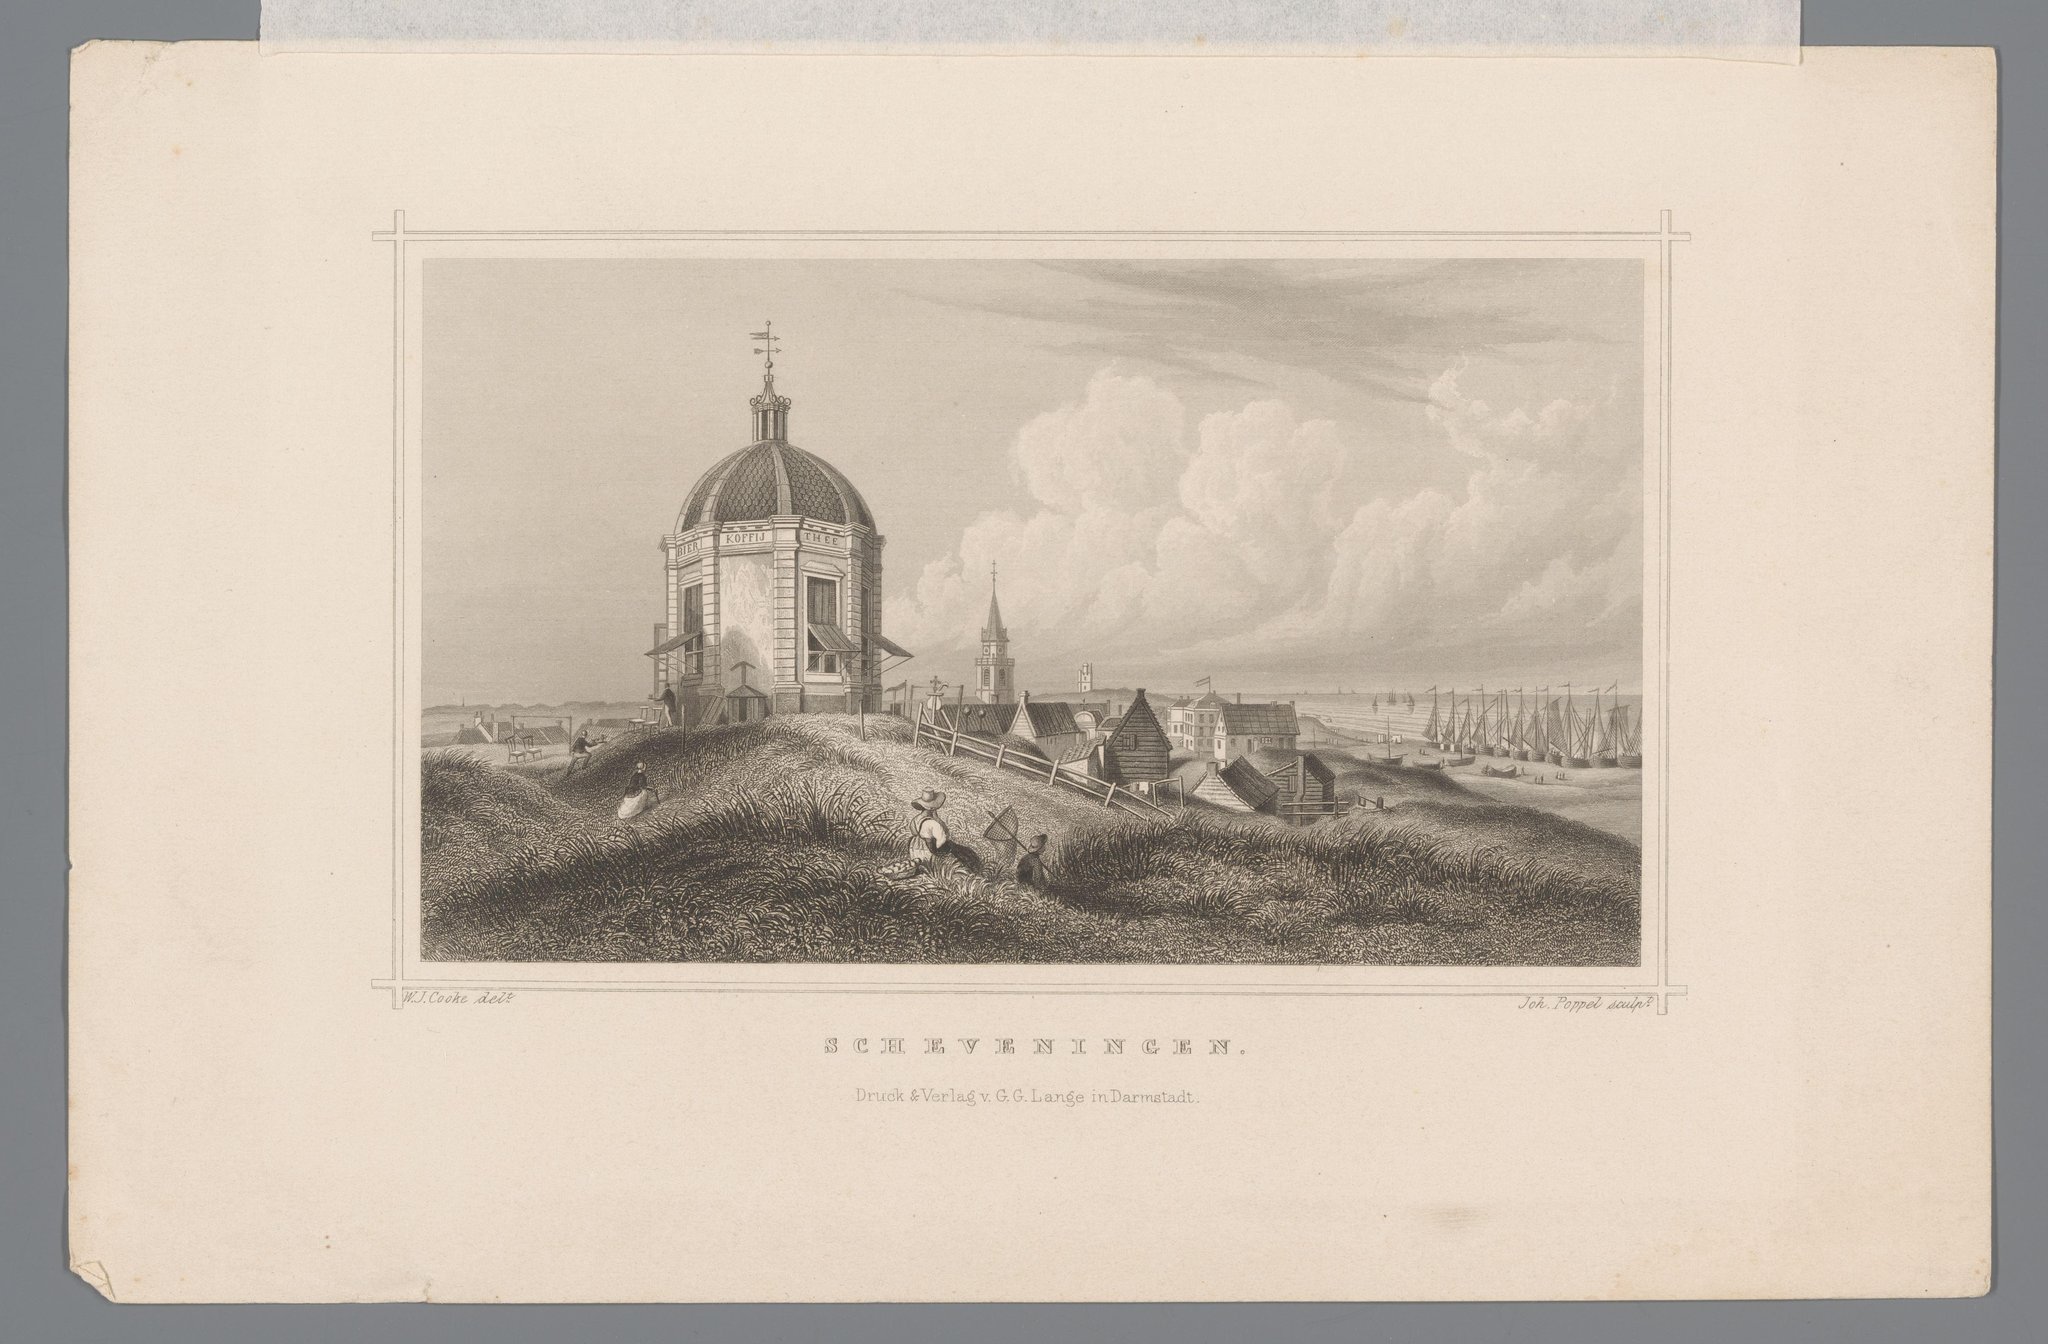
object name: print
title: Scheveningen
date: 1863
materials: paper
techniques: engraving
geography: darmstadt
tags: summer-house, arbour, garden-house (dutch: 'theekoepel'), beach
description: Prent uit: Der Rhein und die Rheinlande in malerischen Original-Ansichten (...). 3 dln. Darmstadt: G.G. Lange, 1863, dl. 3, p. 212-213.